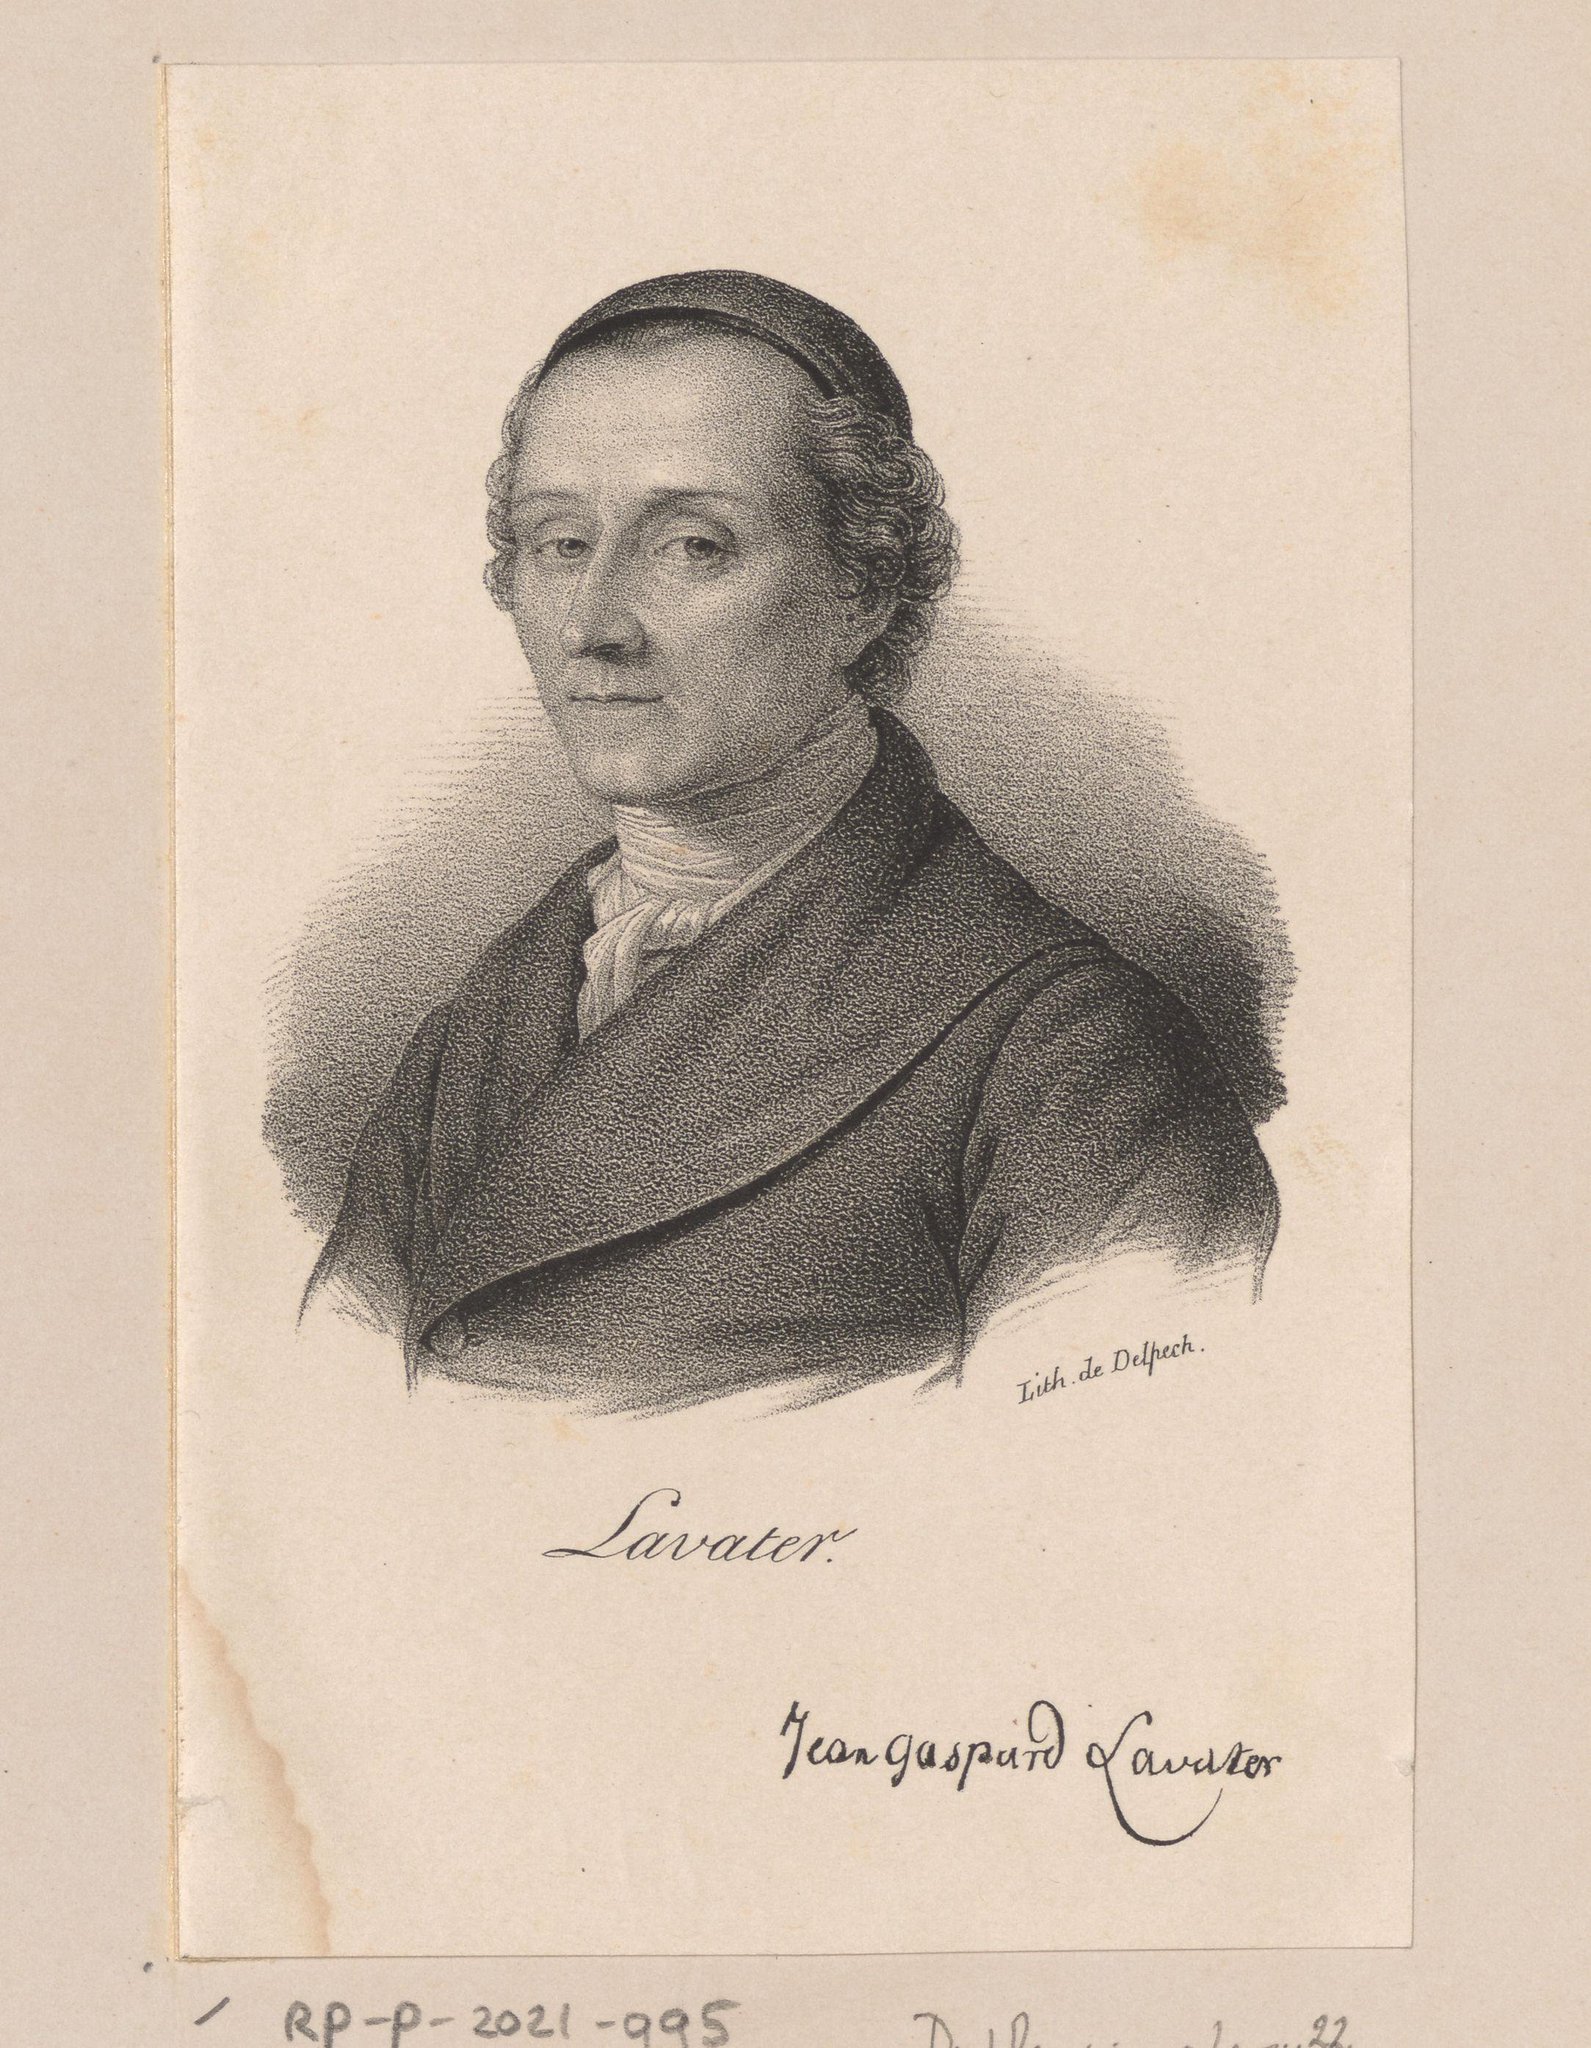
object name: print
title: Portret van Johann Caspar Lavater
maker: Anonymous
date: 1818-1842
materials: paper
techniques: lithograph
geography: france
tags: johann caspar lavater, historical persons, scholar, philosopher (+ portrait of scholar, scientist)